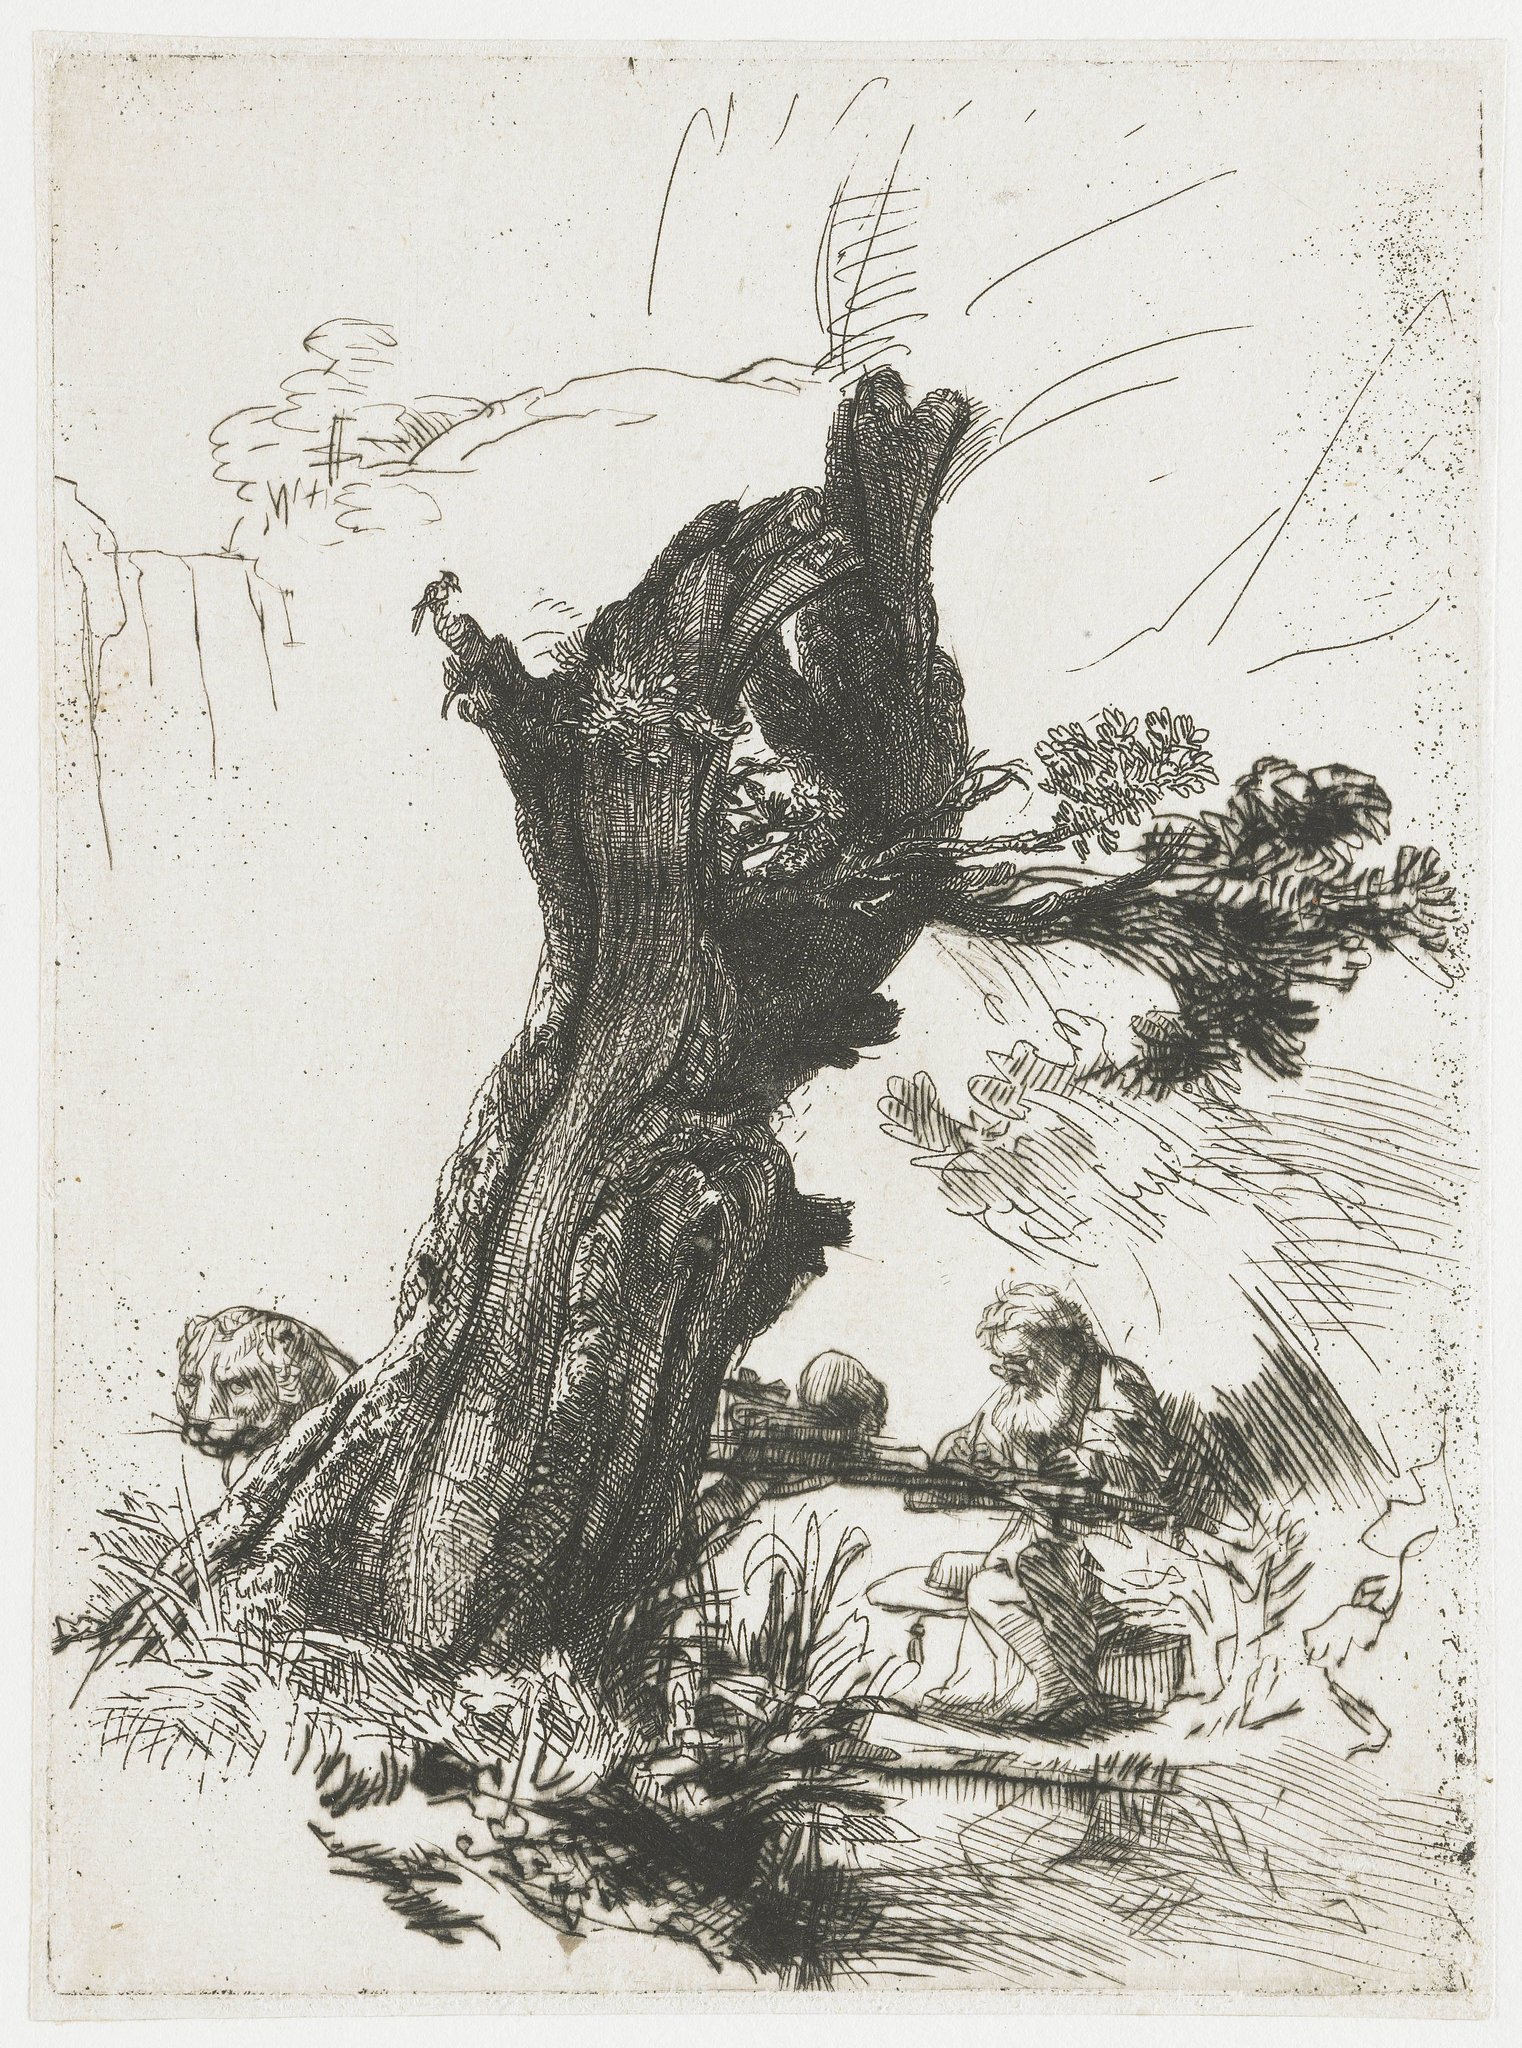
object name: print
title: St Jerome beside a pollard willow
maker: rembrandt van rijn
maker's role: draughtsman, painter, print maker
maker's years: 1606-1669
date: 1648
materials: paper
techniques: drypoint, etching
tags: the monk and hermit jerome (hieronymus); possible attributes: book, cardinal's hat, crucifix, hour-glass, lion, skull, stone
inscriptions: collector's mark: Lugt 240